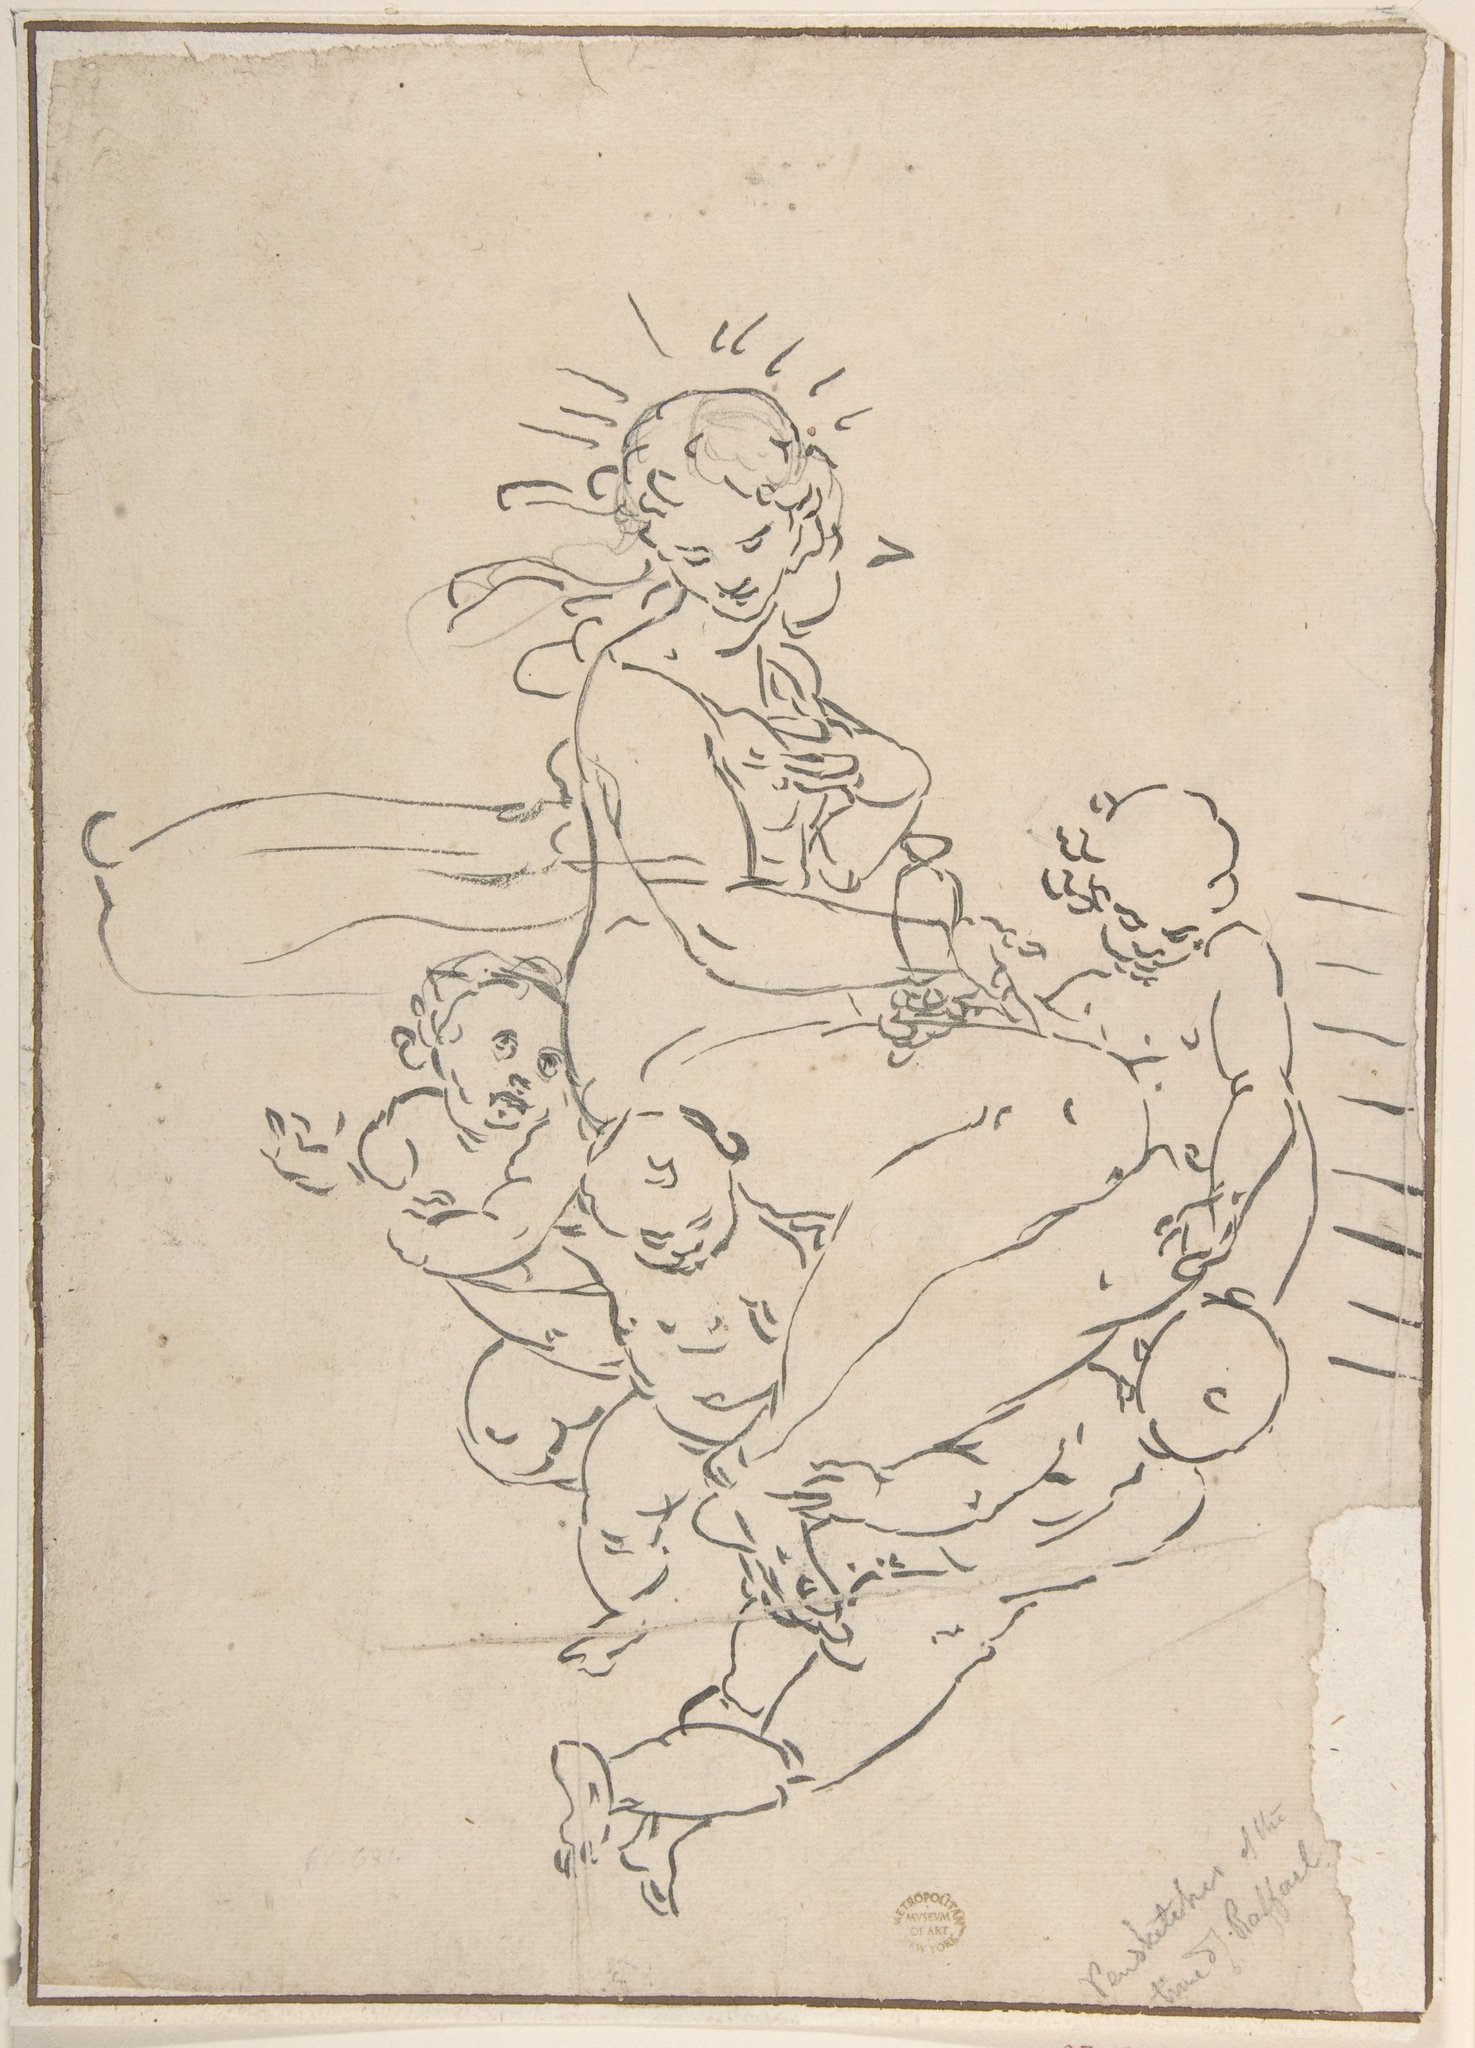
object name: drawing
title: Apotheosis of Saint Mary Magdalen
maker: luca cambiaso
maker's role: artist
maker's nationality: italian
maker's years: 1527-1585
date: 1527-1585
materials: ink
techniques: brush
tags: children,mary magdalene